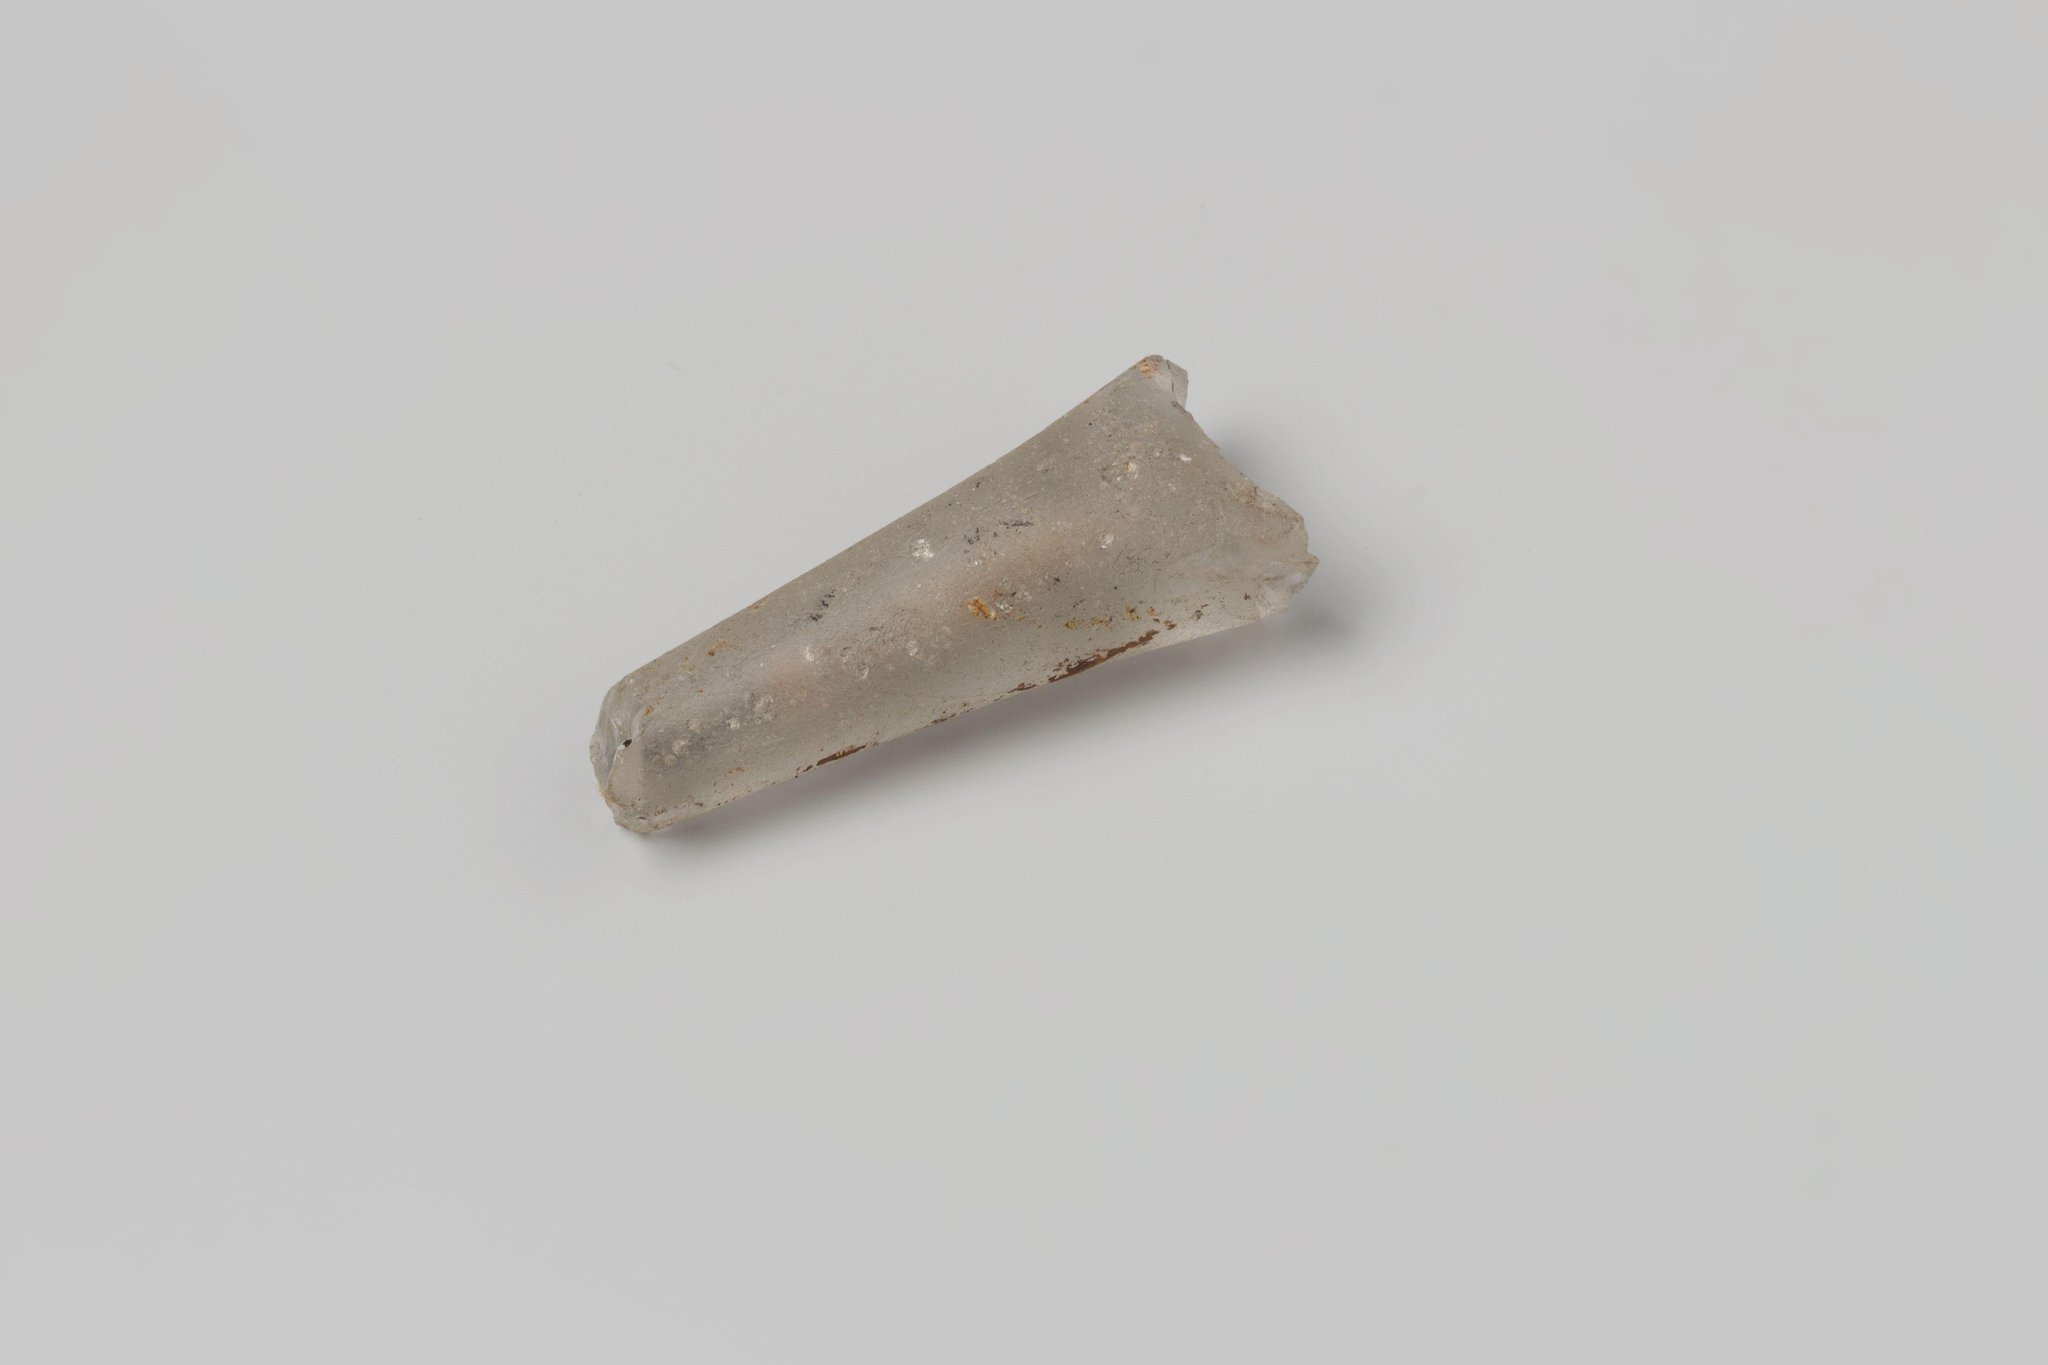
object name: drinking glass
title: Fragment rechte steel van glas uit het wrak van de Oost-Indiëvaarder Hollandia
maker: Anonymous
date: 1700-1743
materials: glass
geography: netherlands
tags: verenigde oostindische compagnie, hollandia (schip), annet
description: Glass, stem glass, stems, plain; fragm, id. NG 1980-27H798.